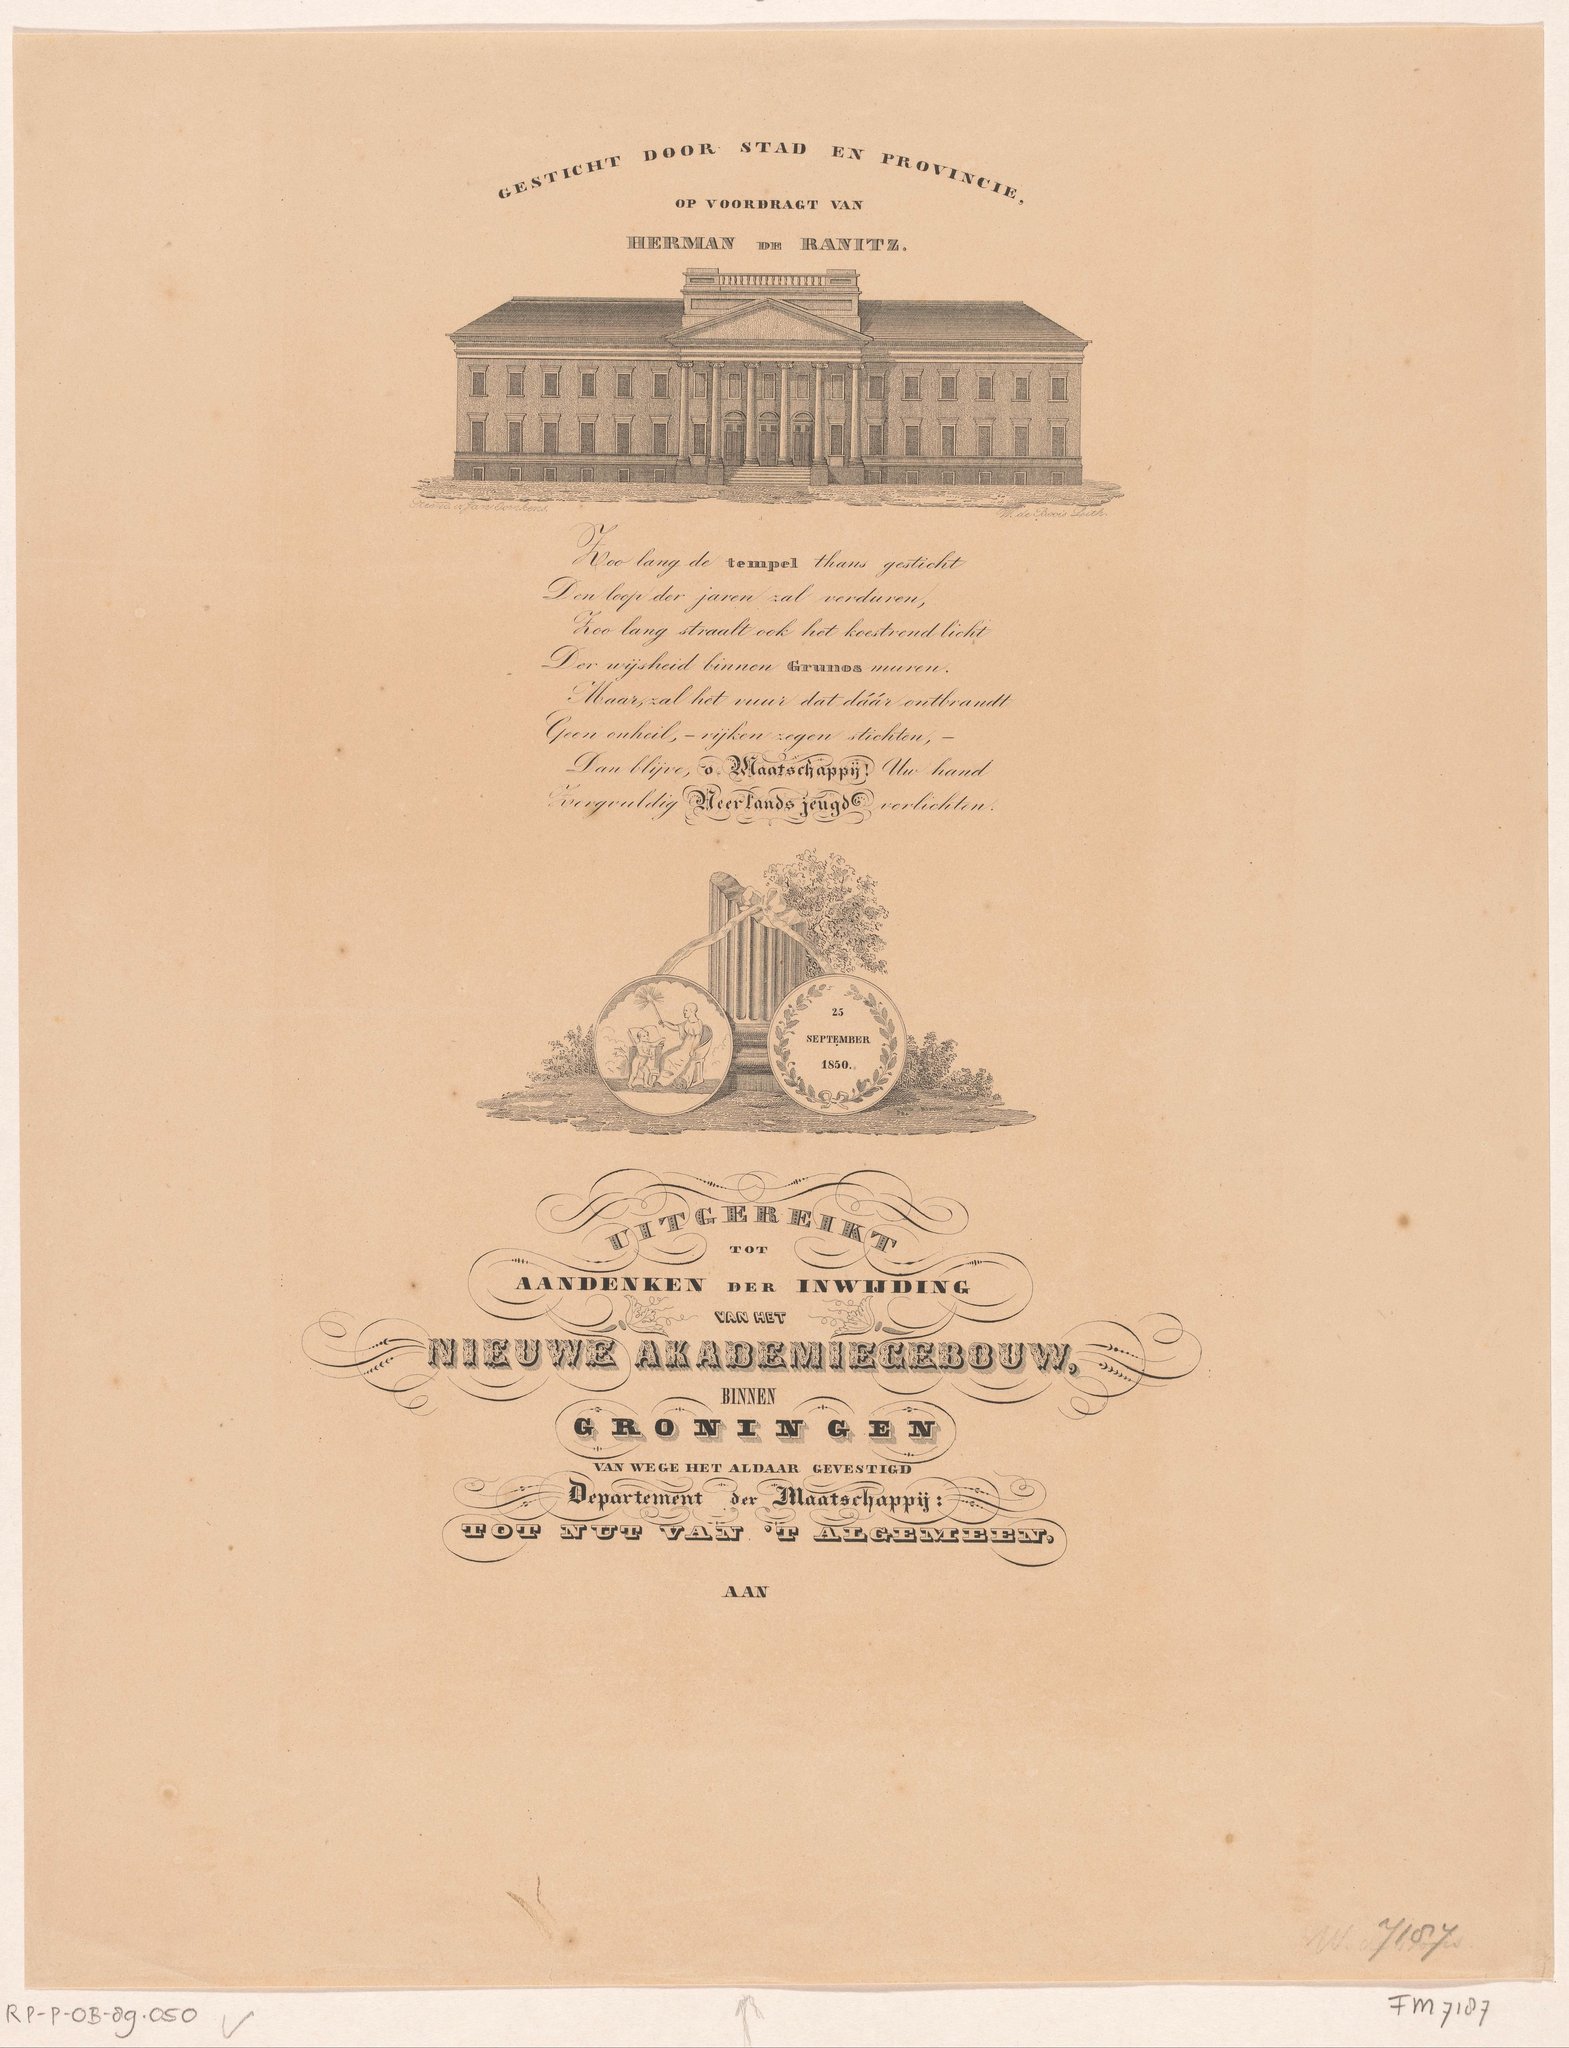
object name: print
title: Aandenken bij de inwijding van het nieuwe academiegebouw van de Hogeschool van Groningen, 1850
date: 1850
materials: paper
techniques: lithograph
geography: groningen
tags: picture, painting, university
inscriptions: collector's mark: Lugt 2228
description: Het nieuwe academiegebouw van de Hogeschool van Groningen, ingewijd op 25 sepetember 1850, gesticht op voordracht van Herman de Ranitz. Afbeelding van de façade, een achtregelig vers op de studietempel, de gedenkpenning bij deze gebeurtenis geslagen. Onderaan is de naam aan wie dit aandenken is uitgereikt niet ingevuld. De prent werd uitgereikt door het Groningse departement van de Maatschappij tot Nut van 't Algemeen.